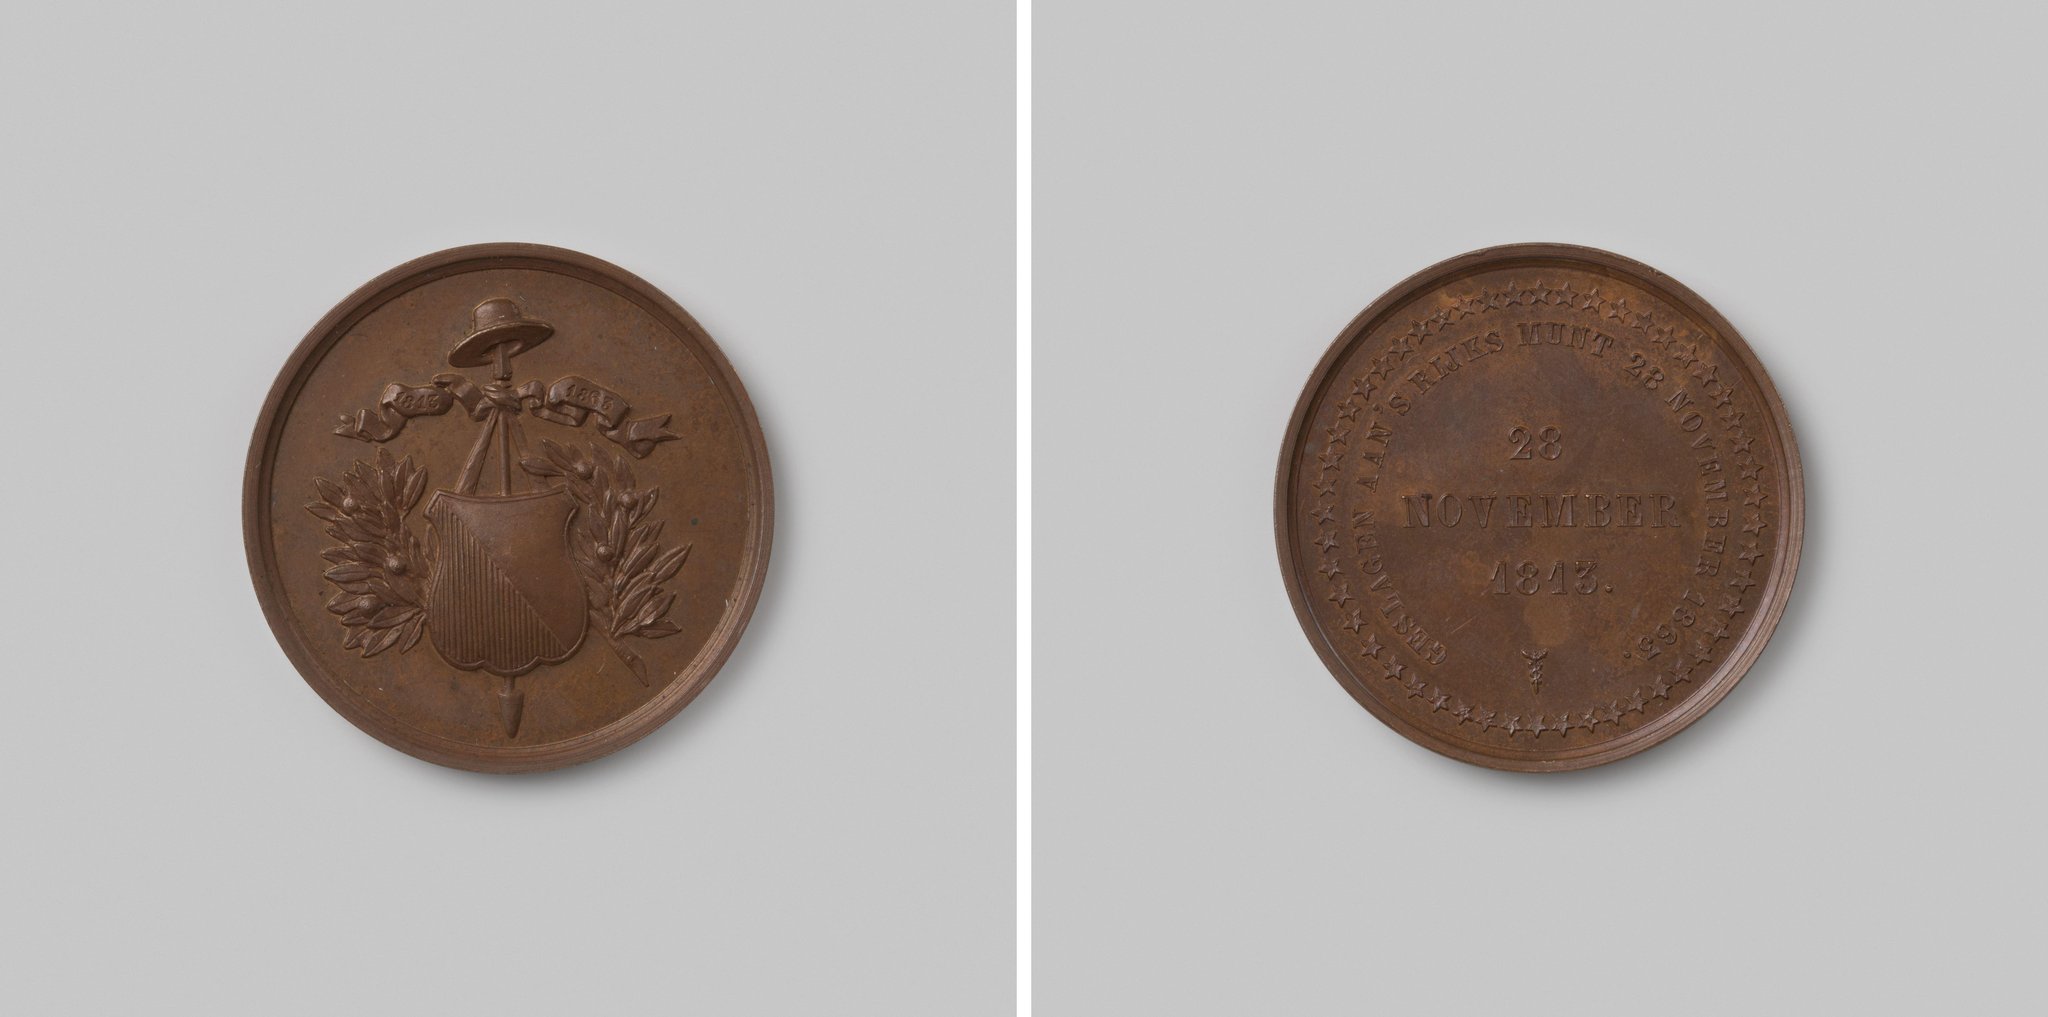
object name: history medal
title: Vijftigjarige viering van kozakjesdag: herdenking van het binnentrekken van de kozakken te Utrecht, penning geslagen door de Rijksmunt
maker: Anonymous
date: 1863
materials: bronze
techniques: striking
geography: utrecht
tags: utrecht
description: Bronzen penning. Voorzijde: wapenschild omgeven door oranjetakken, met wimpel vastgebonden aan speer, bekroond door vrijheidshoed. Keerzijde: datering binnen omschrift.